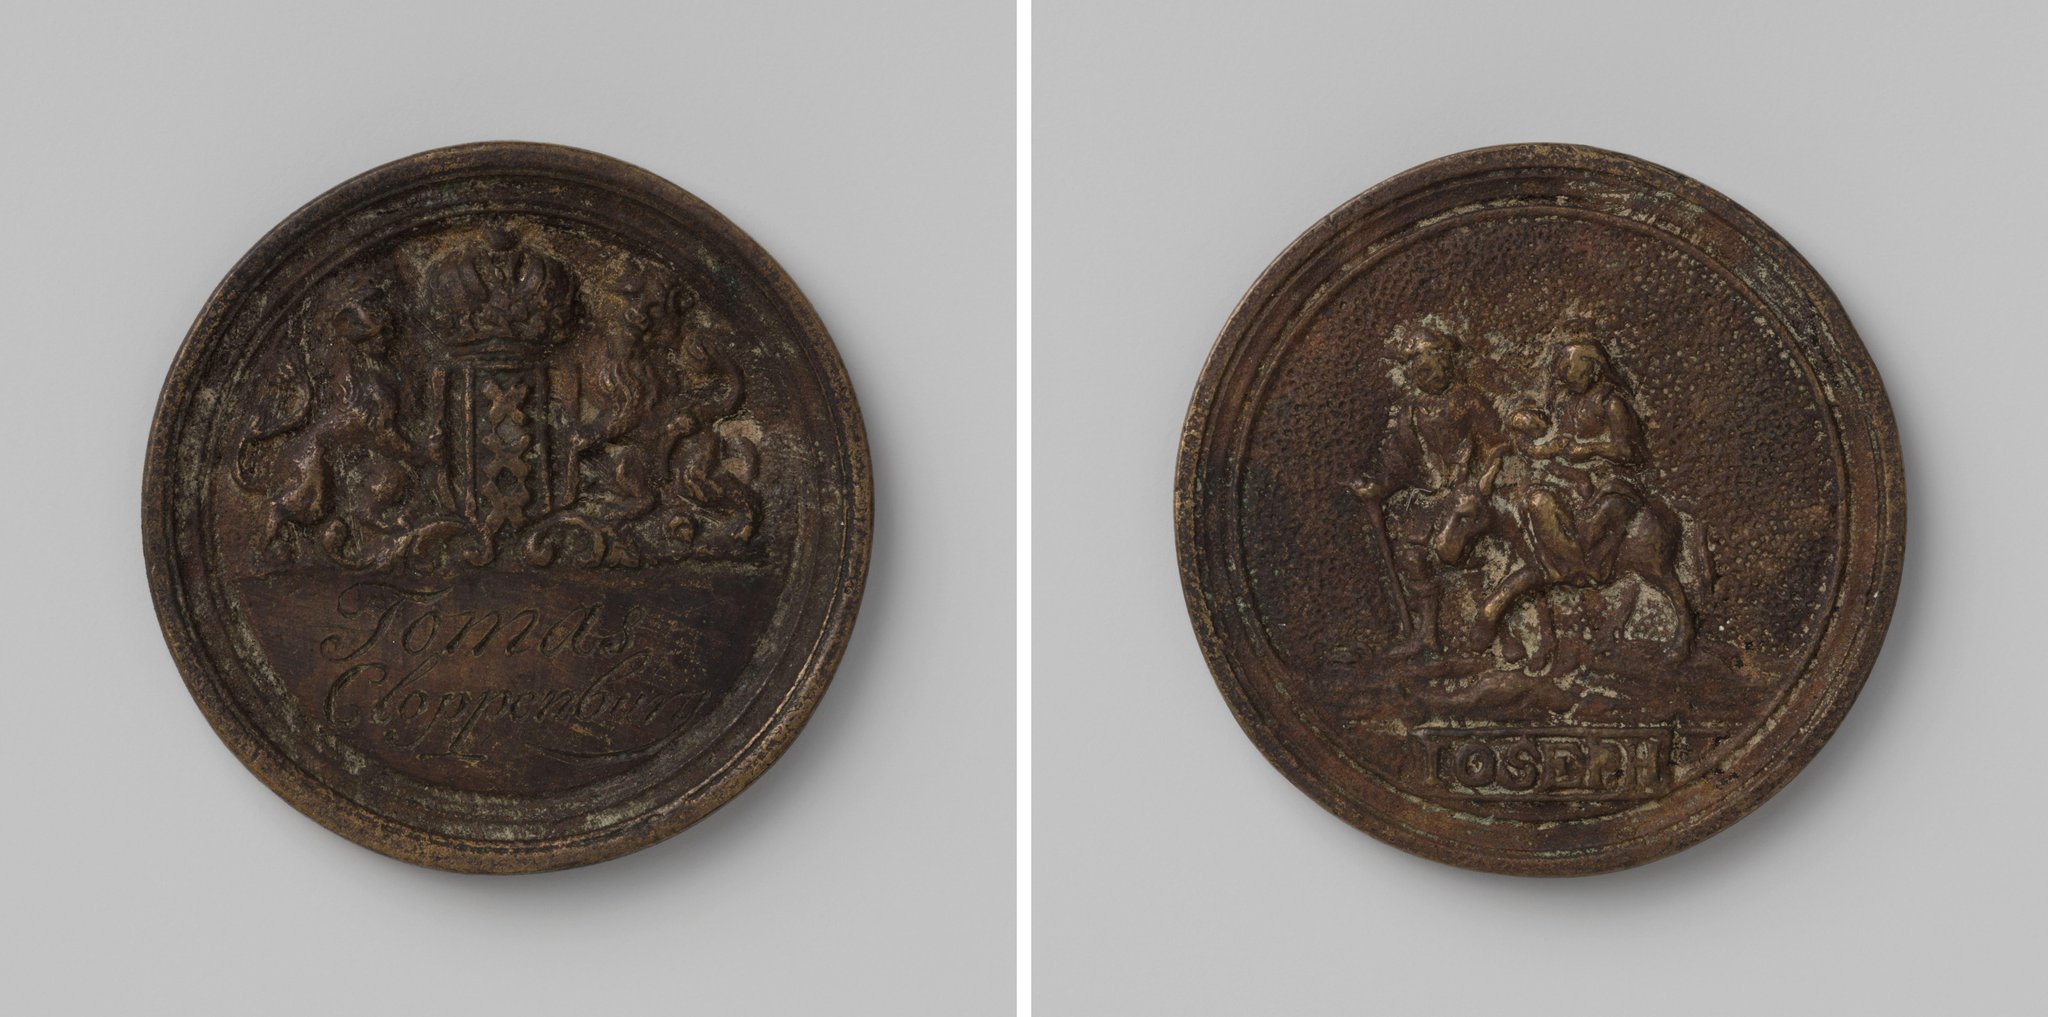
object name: medal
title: Timmerliedengilde van Amsterdam, gildepenning van Tomas Cloppenburg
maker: Anonymous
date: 1749-1808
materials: brass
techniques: casting, engraving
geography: amsterdam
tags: amsterdam